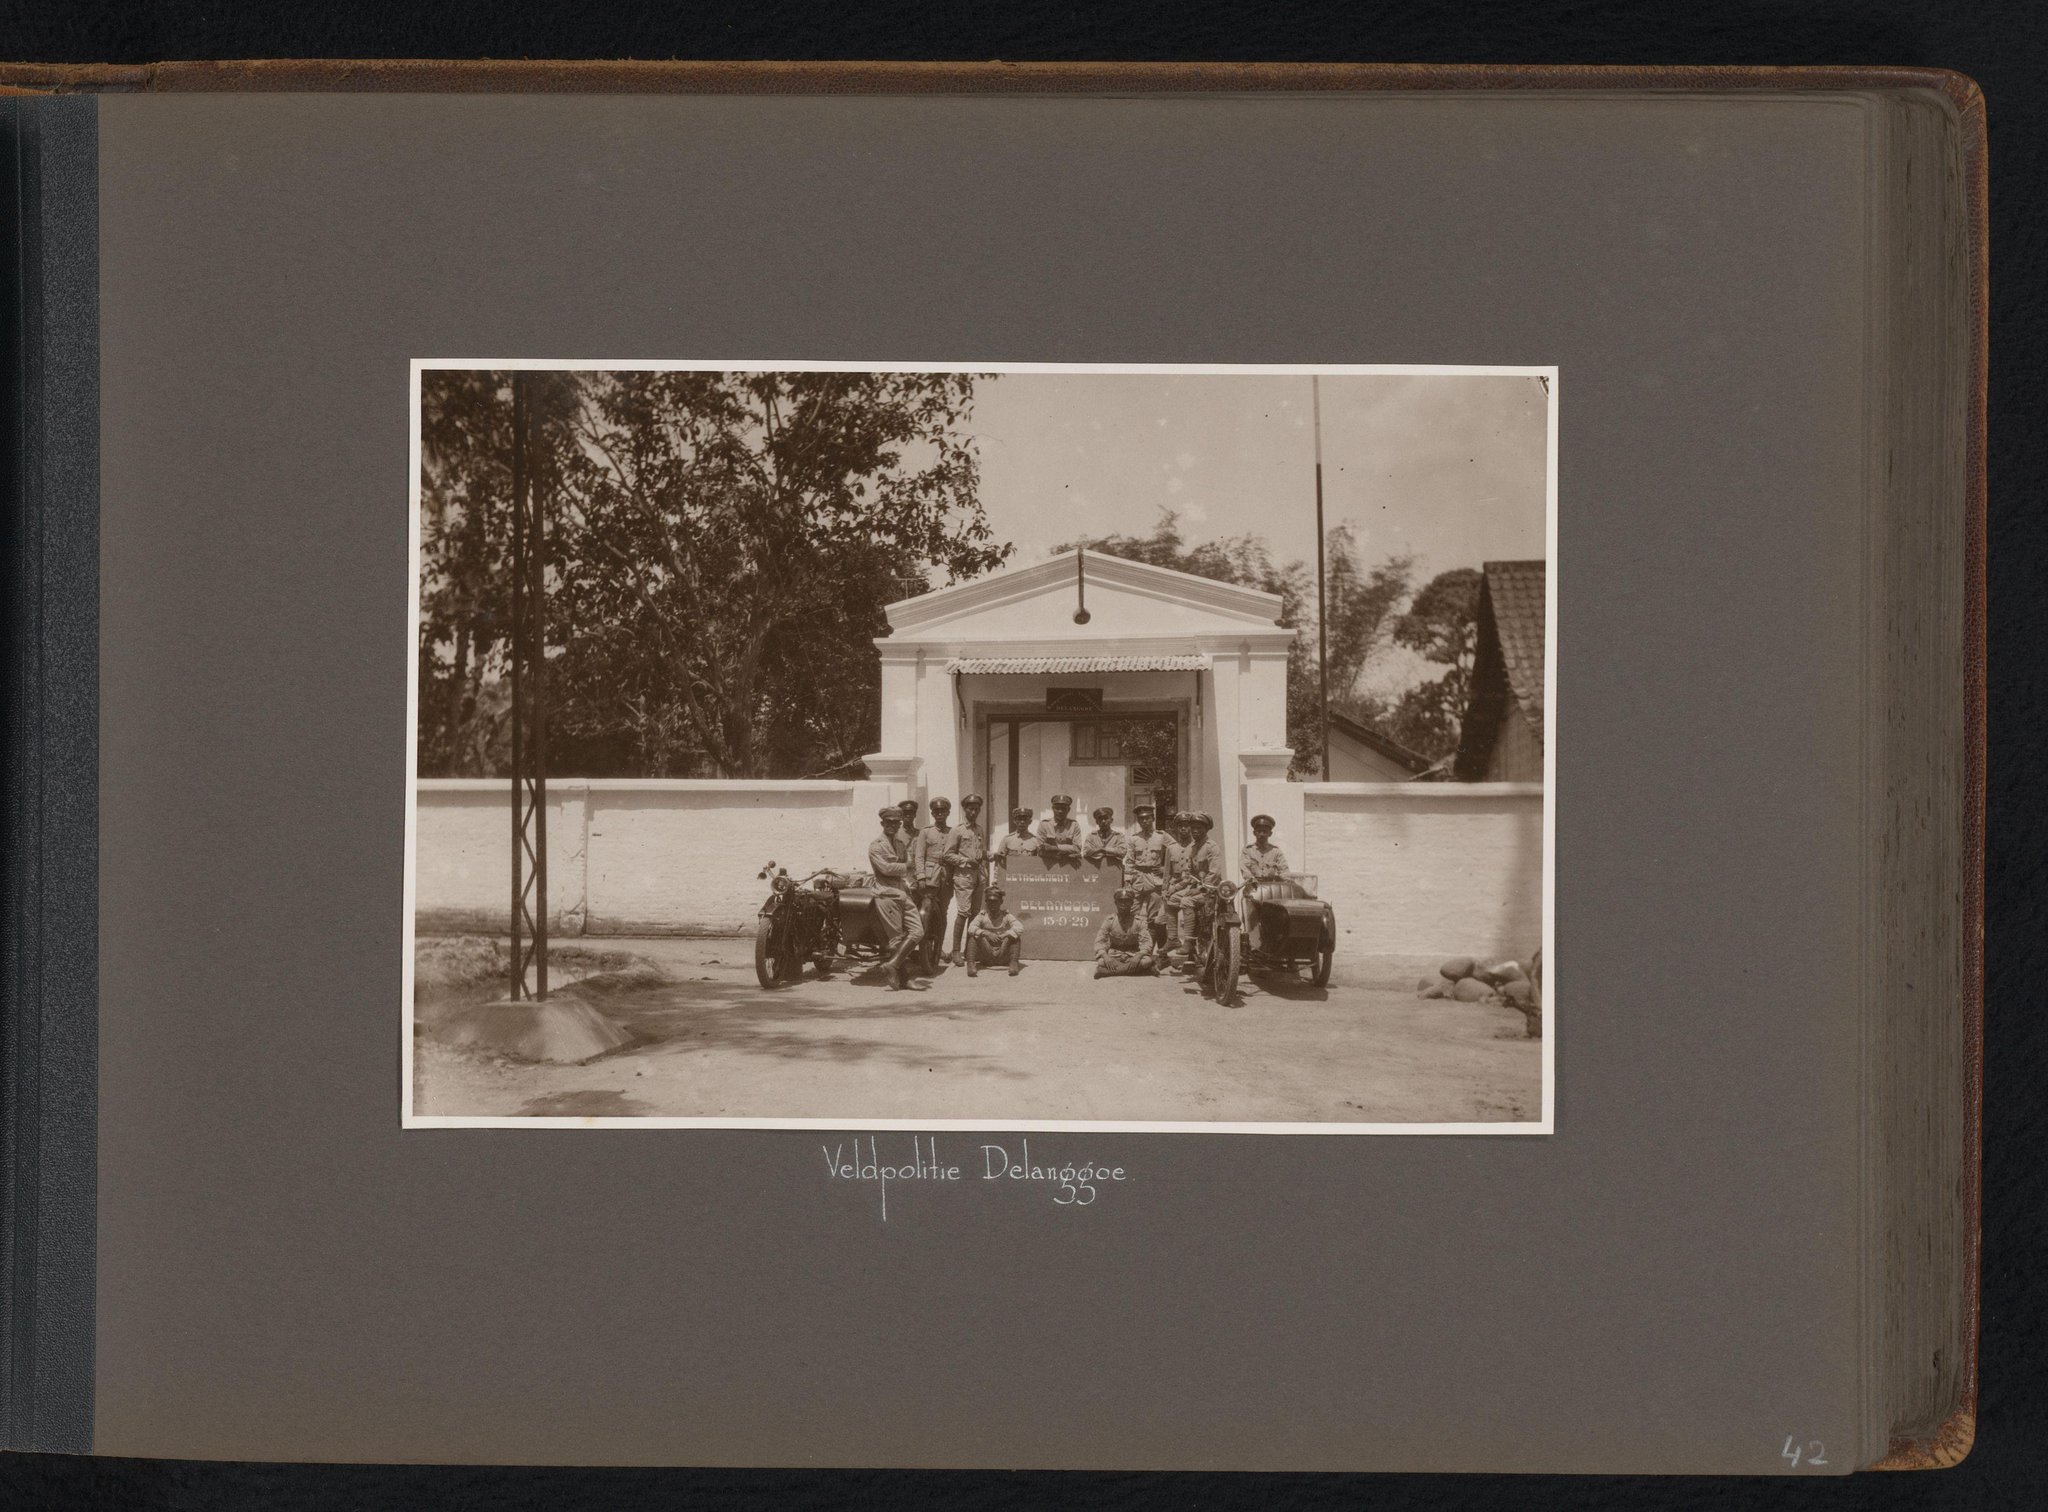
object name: photograph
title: Veldpolitie Delanggoe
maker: Anonymous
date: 1929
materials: cardboard, photographic support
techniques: gelatin silver print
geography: java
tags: java, dutch east indies, the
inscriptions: date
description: Albumblad met één foto: agenten van het detachement veldpolitie te Delanggoe, 13 september 1929. Onderdeel van het fotoalbum aangeboden aan S. Koster door de Vereeniging van Hoogere Politie Ambtenaren in Nederlandsch-Indië in 1931.